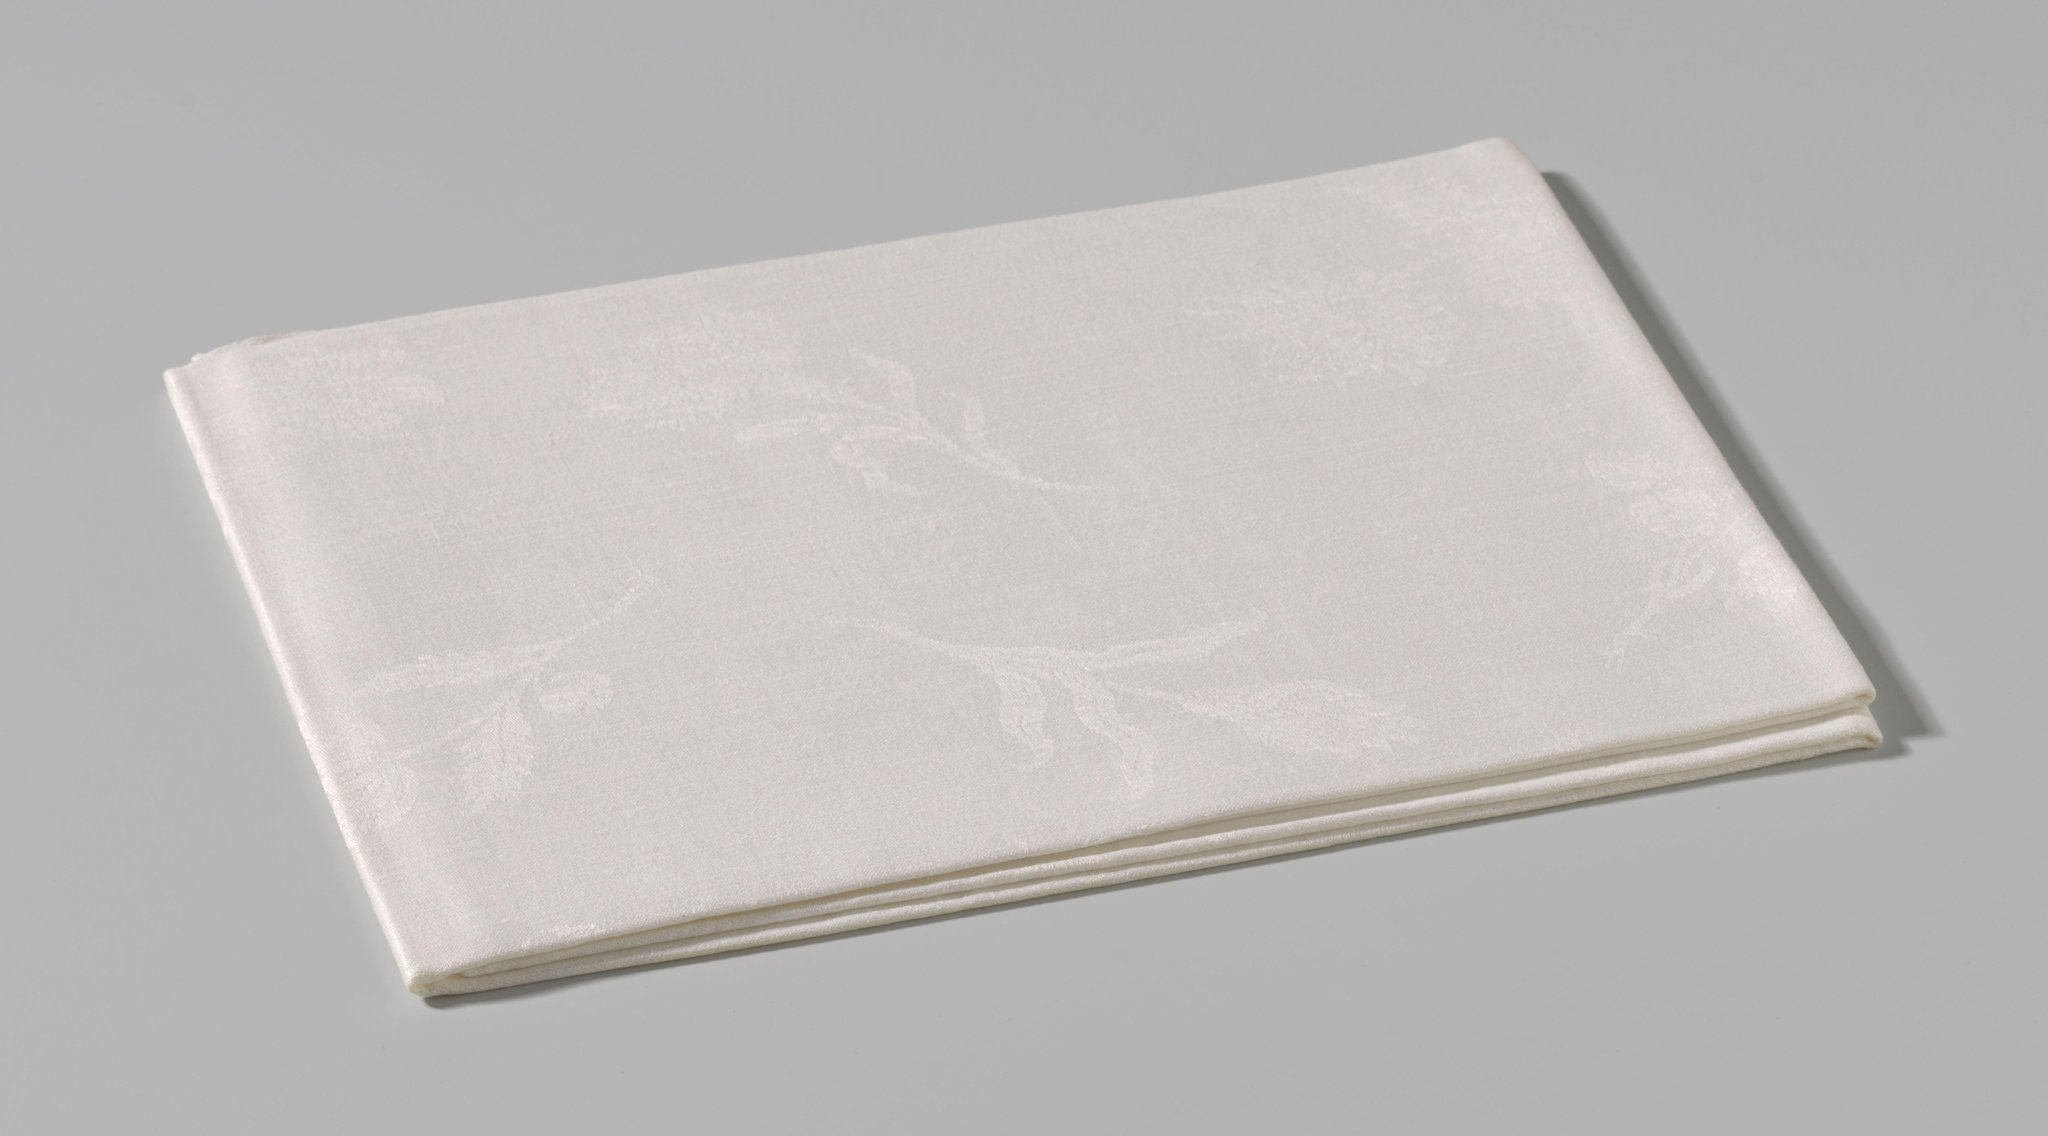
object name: napkin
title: Servet met een bloempatroon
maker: Anonymous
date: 1750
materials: linen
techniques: damask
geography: dresden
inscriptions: mark: ‘B’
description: Servet van linnendamast met een bloempatroon. Onder andere: roos, ranonkel, lelietje van dalen, anjer, tulp; met stelen die schuin en in rijen tegengesteld gericht zijn. Staande rand: dunne lopende voluutranken, waaraan onder andere kelkbloemen, papaver, chrysant, akelei, en wordt begrensd door grote asymmetrische rocaillemotieven, die op de hoeken naar het midden zijn gericht. Rondom: blokkenrand.